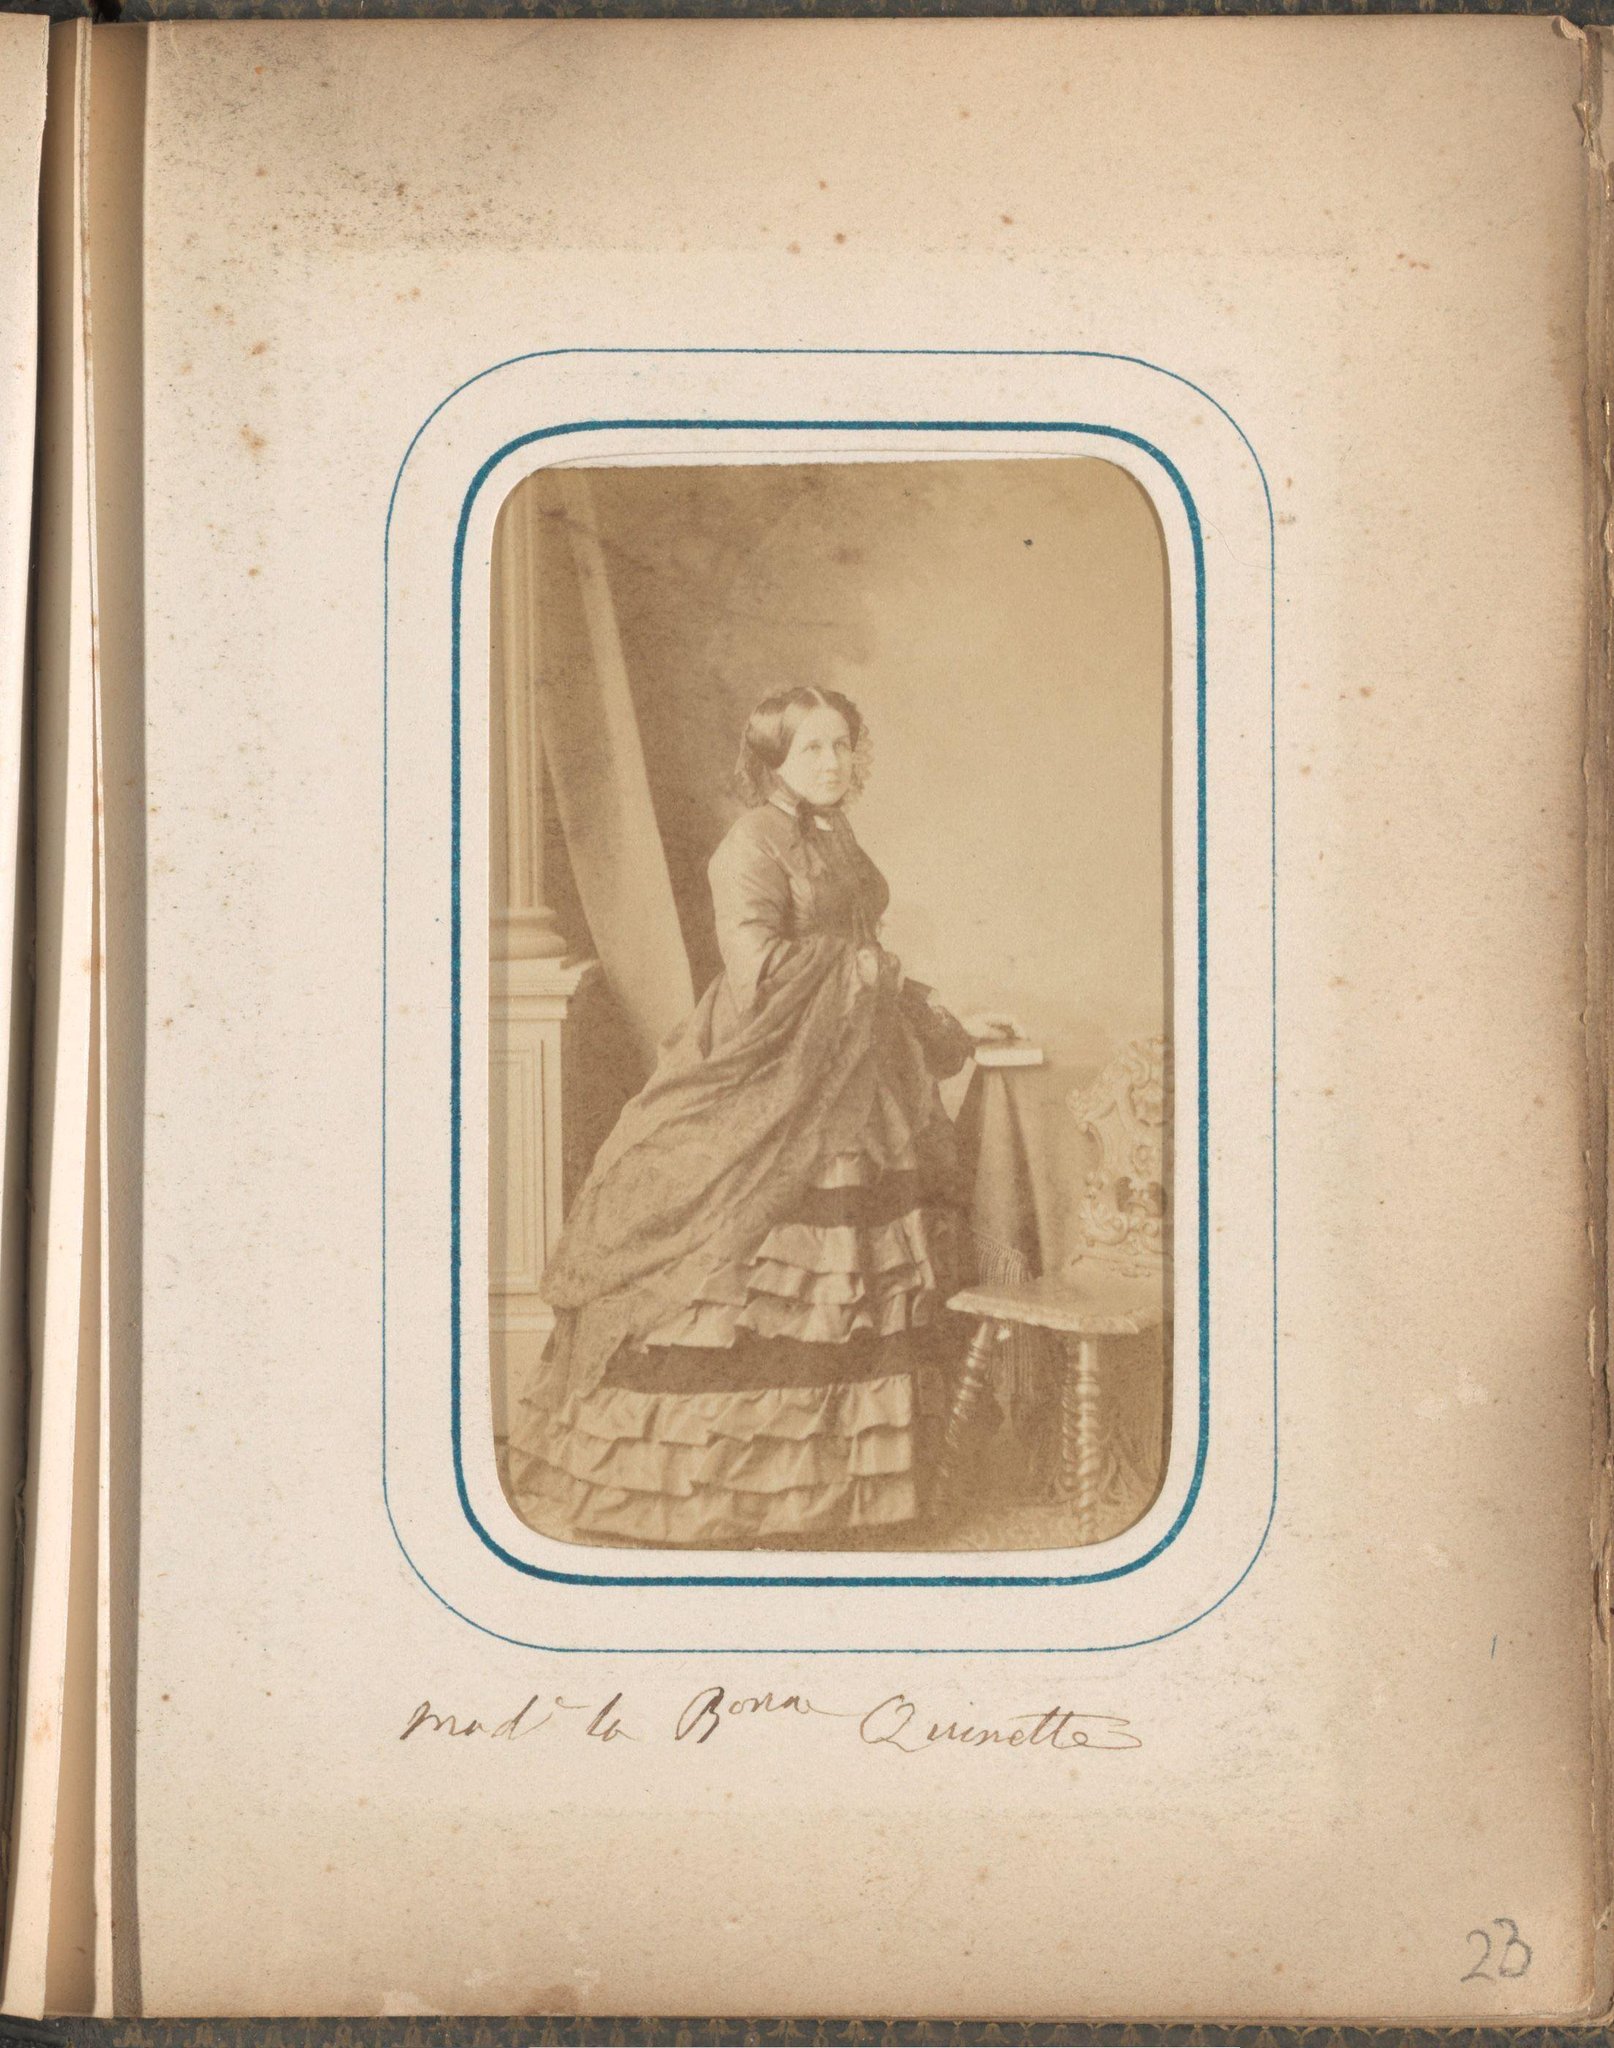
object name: photograph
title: Portret van mevrouw La Bonan Quinette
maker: Anonymous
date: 1860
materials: cardboard, paper, photographic support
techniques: albumen print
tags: studio requisites ~ photographer, historical persons, styles of hairdress - aa - ~ women, dress, gown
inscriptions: name: ‘Mad. la Bonan Quinette’, date: ‘1860’, name: ‘Mad. Quinette’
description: Onderdeel van Fotoalbum met 24 cartes-de-visite van Franse personen.